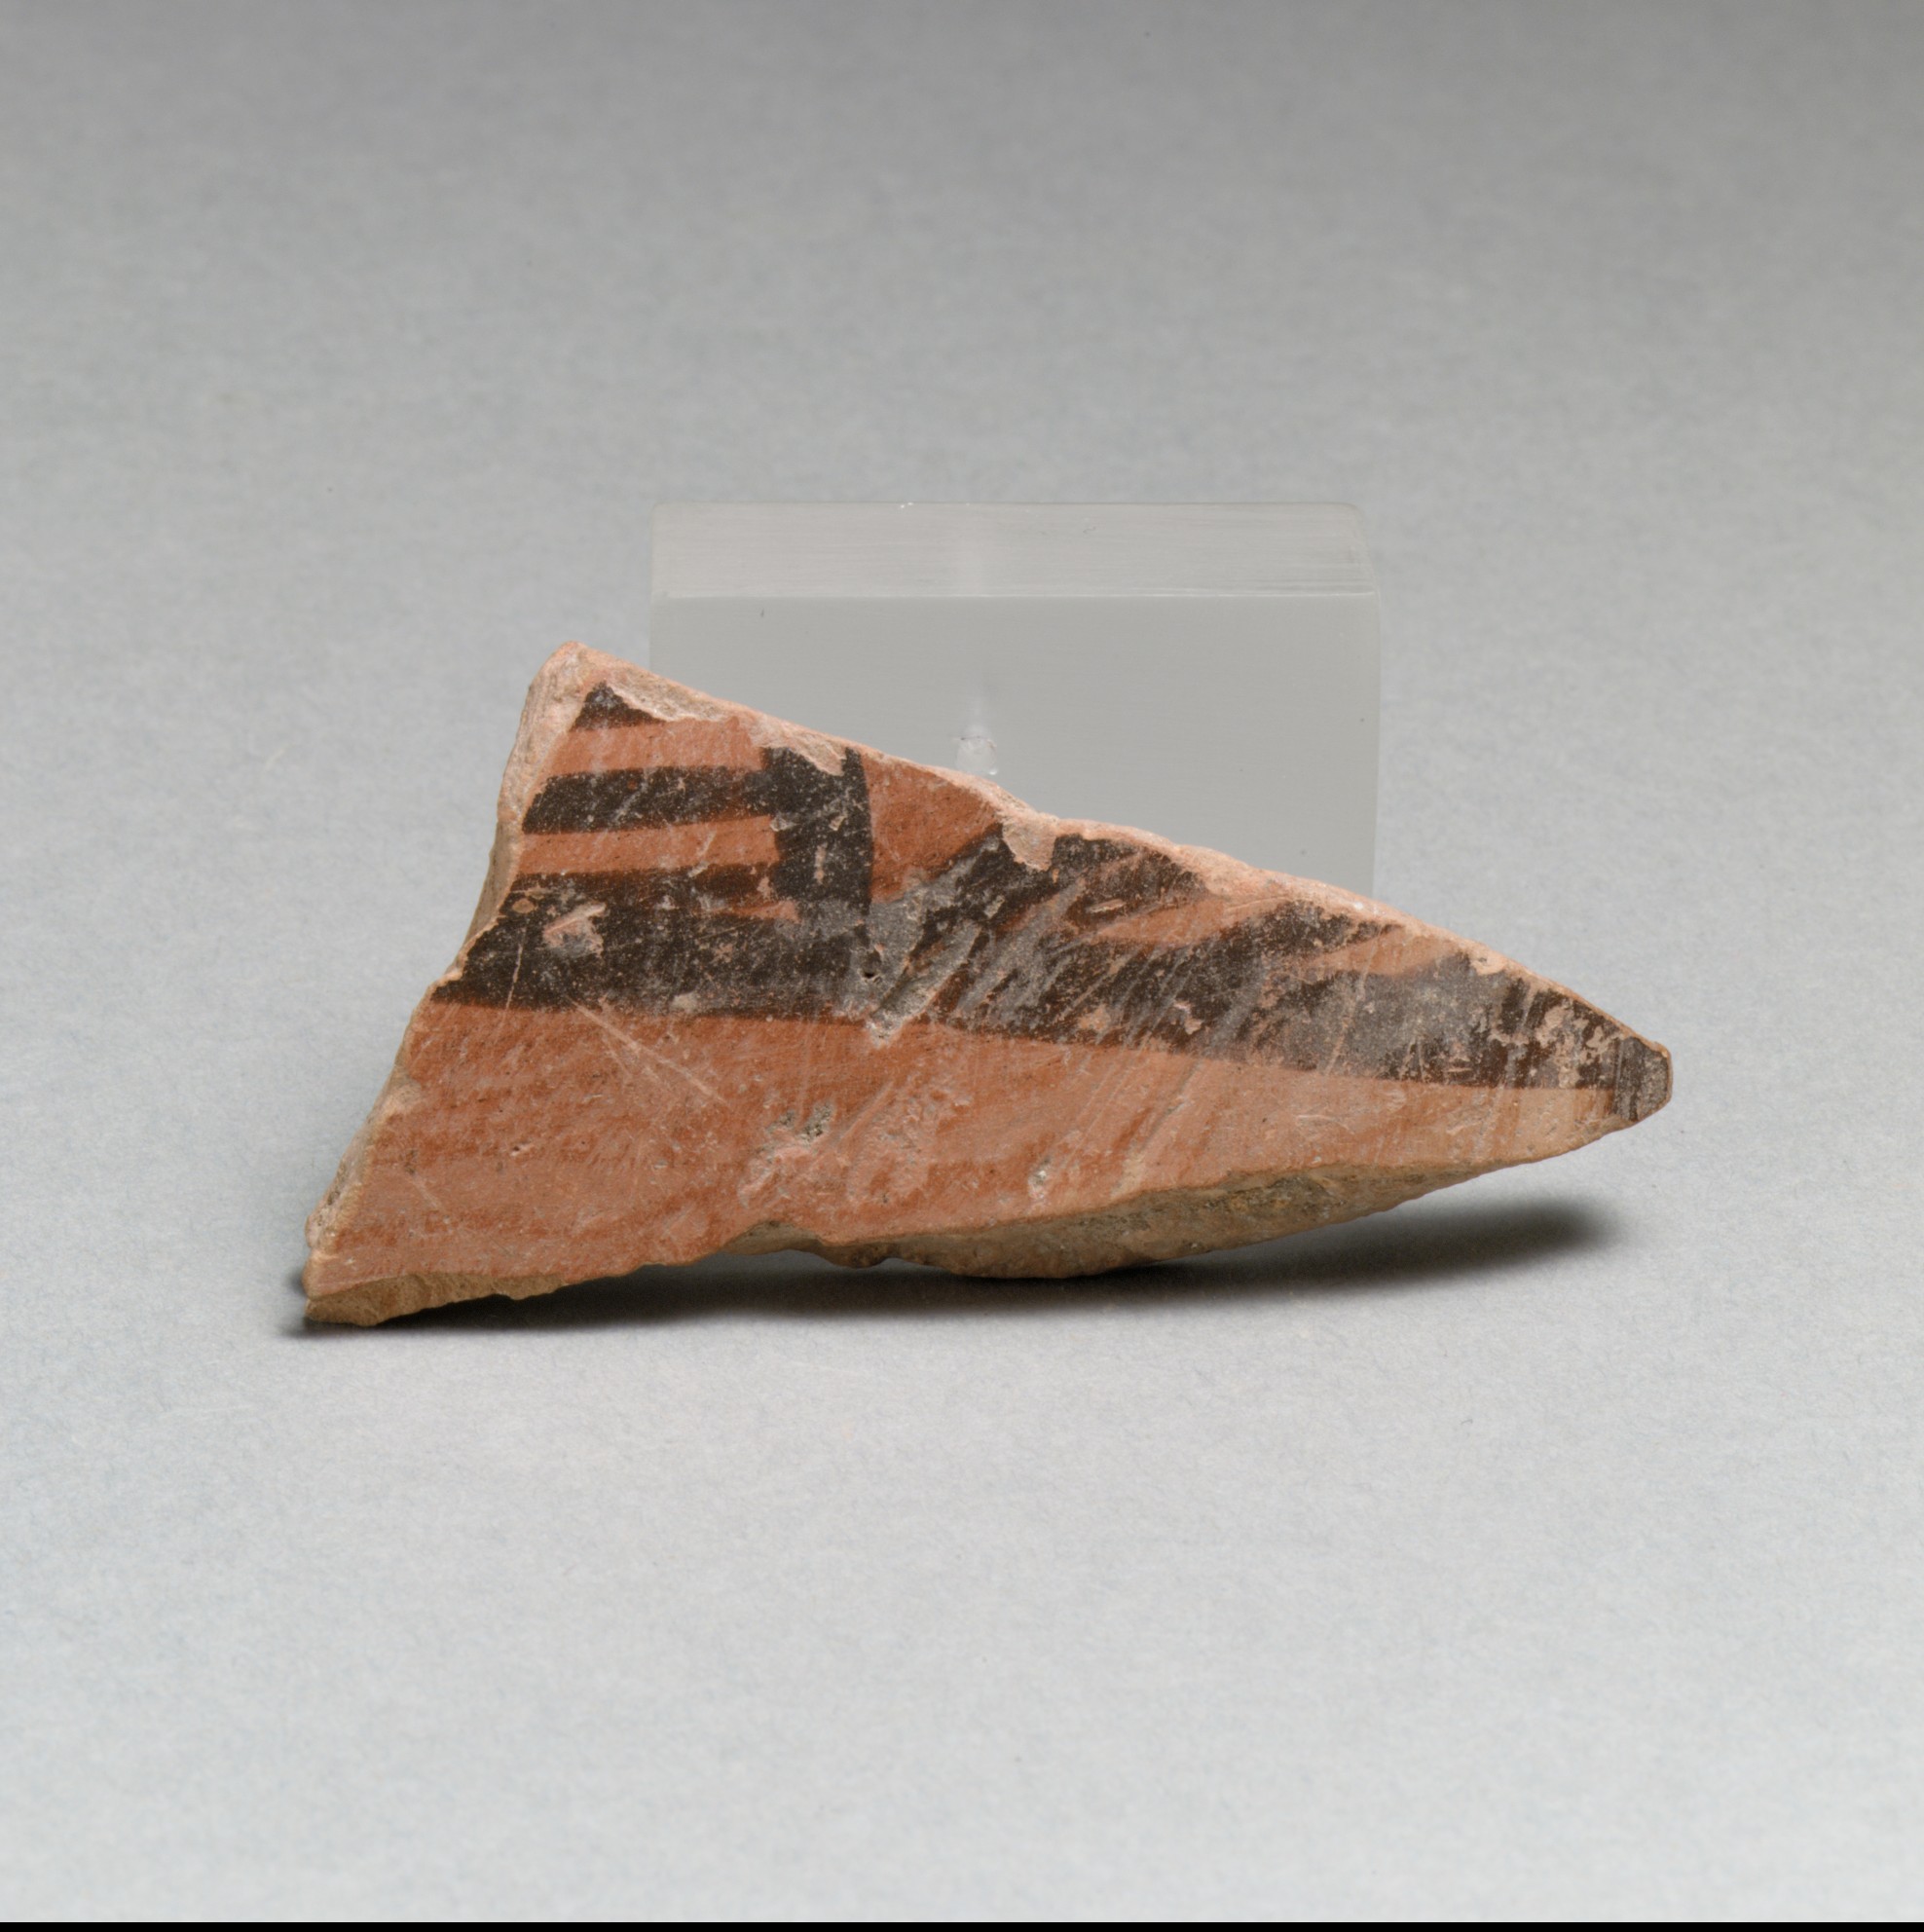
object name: vase fragment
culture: neolithic, thessaly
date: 4000-3000 BCE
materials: terracotta